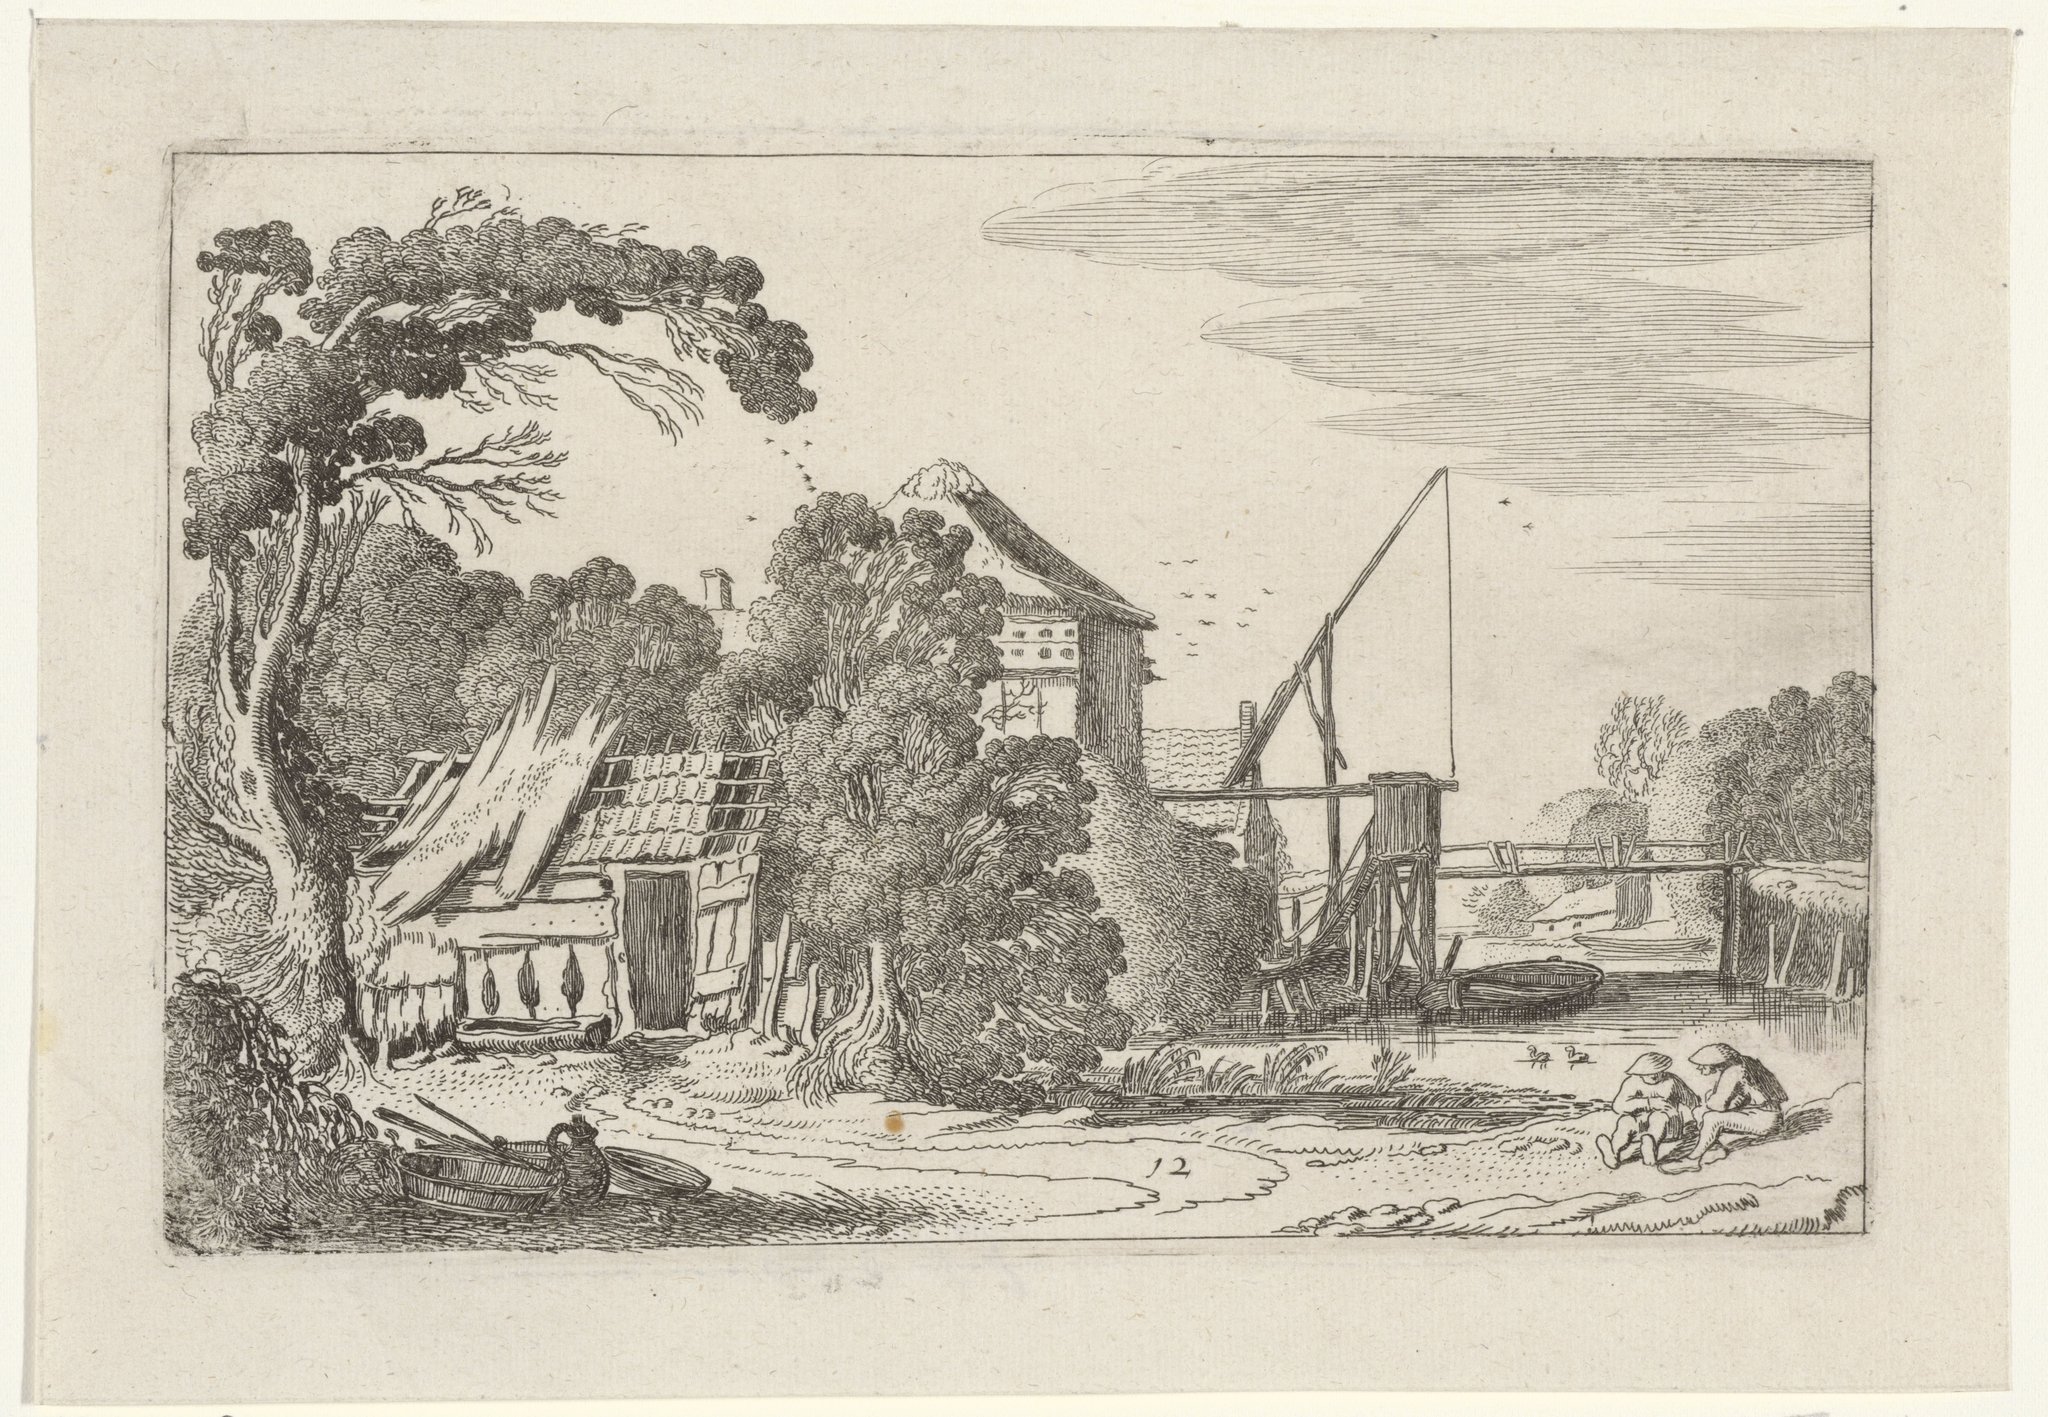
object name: print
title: Ruïnes in landschappen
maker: jan van de velde (ii)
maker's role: draughtsman, painter, print maker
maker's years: 1593-1641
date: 1616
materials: paper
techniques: etching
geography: northern netherlands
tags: barn, landscape with ruins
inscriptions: collector's mark: Lugt 240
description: Twee figuren bij een vervallen schuur in een landschap. Twaalfde prent van een serie van zestien.